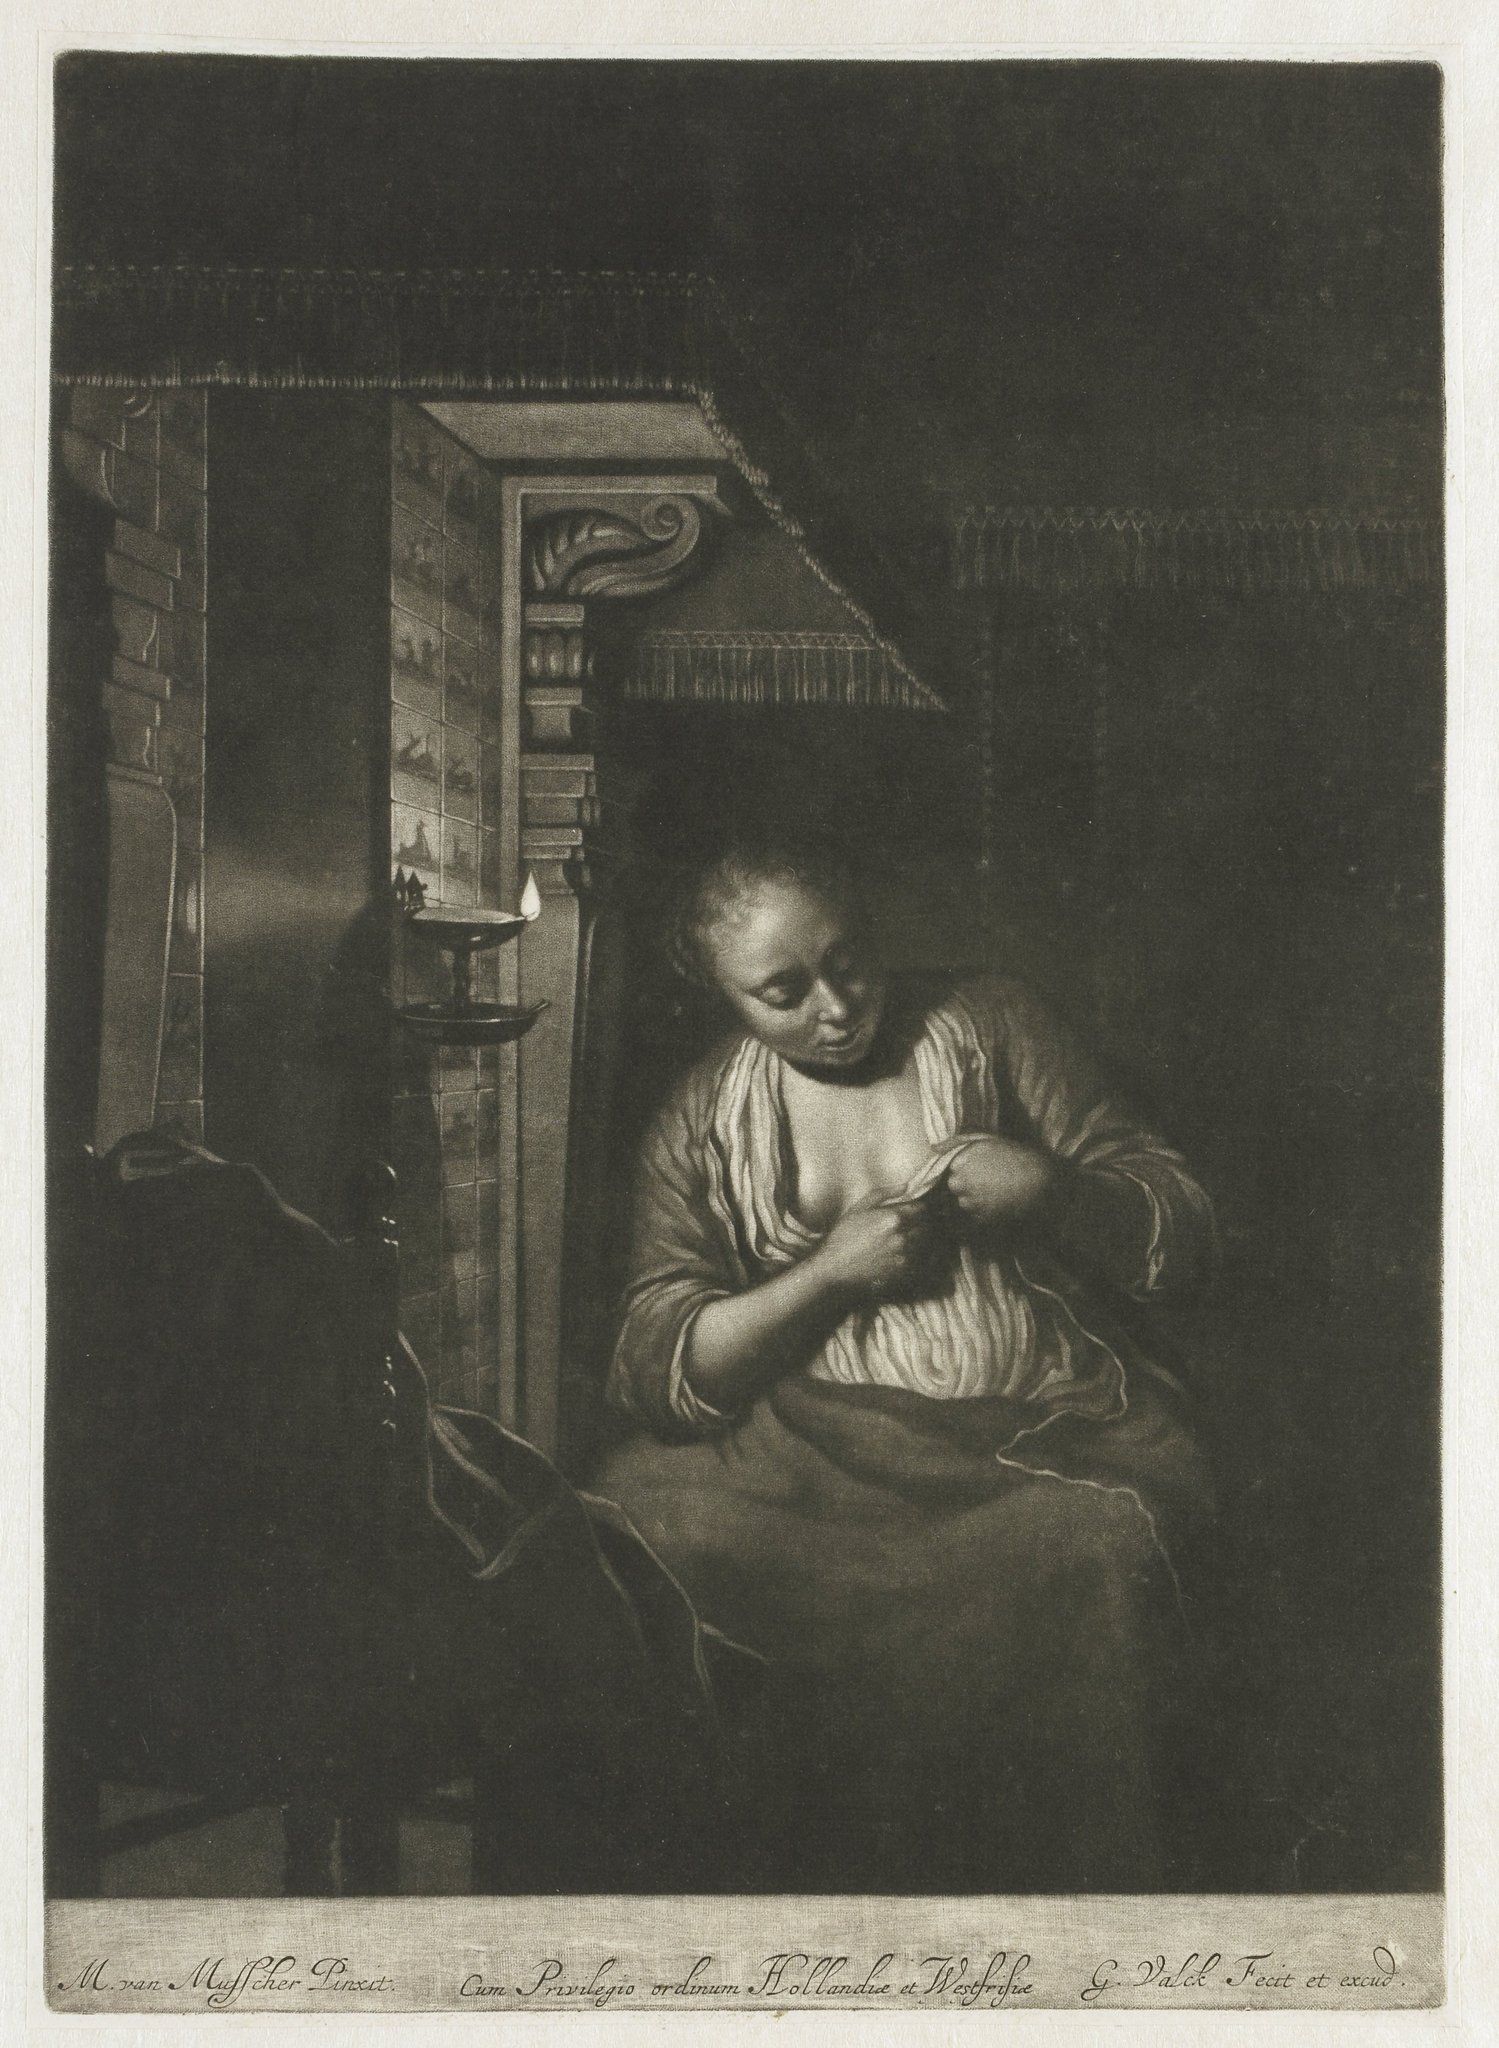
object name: print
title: Zich vlooiende vrouw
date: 1662-1726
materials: paper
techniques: mezzotint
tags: chimney, oil-lamp, tiles, bricks ~ building material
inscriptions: collector's mark: Lugt 10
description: Bij het licht van een olielamp zoekt een jonge vrouw in haar kleding naar vlooien. Ze zit bij een schouw die gedecoreerd is met tegeltjes.